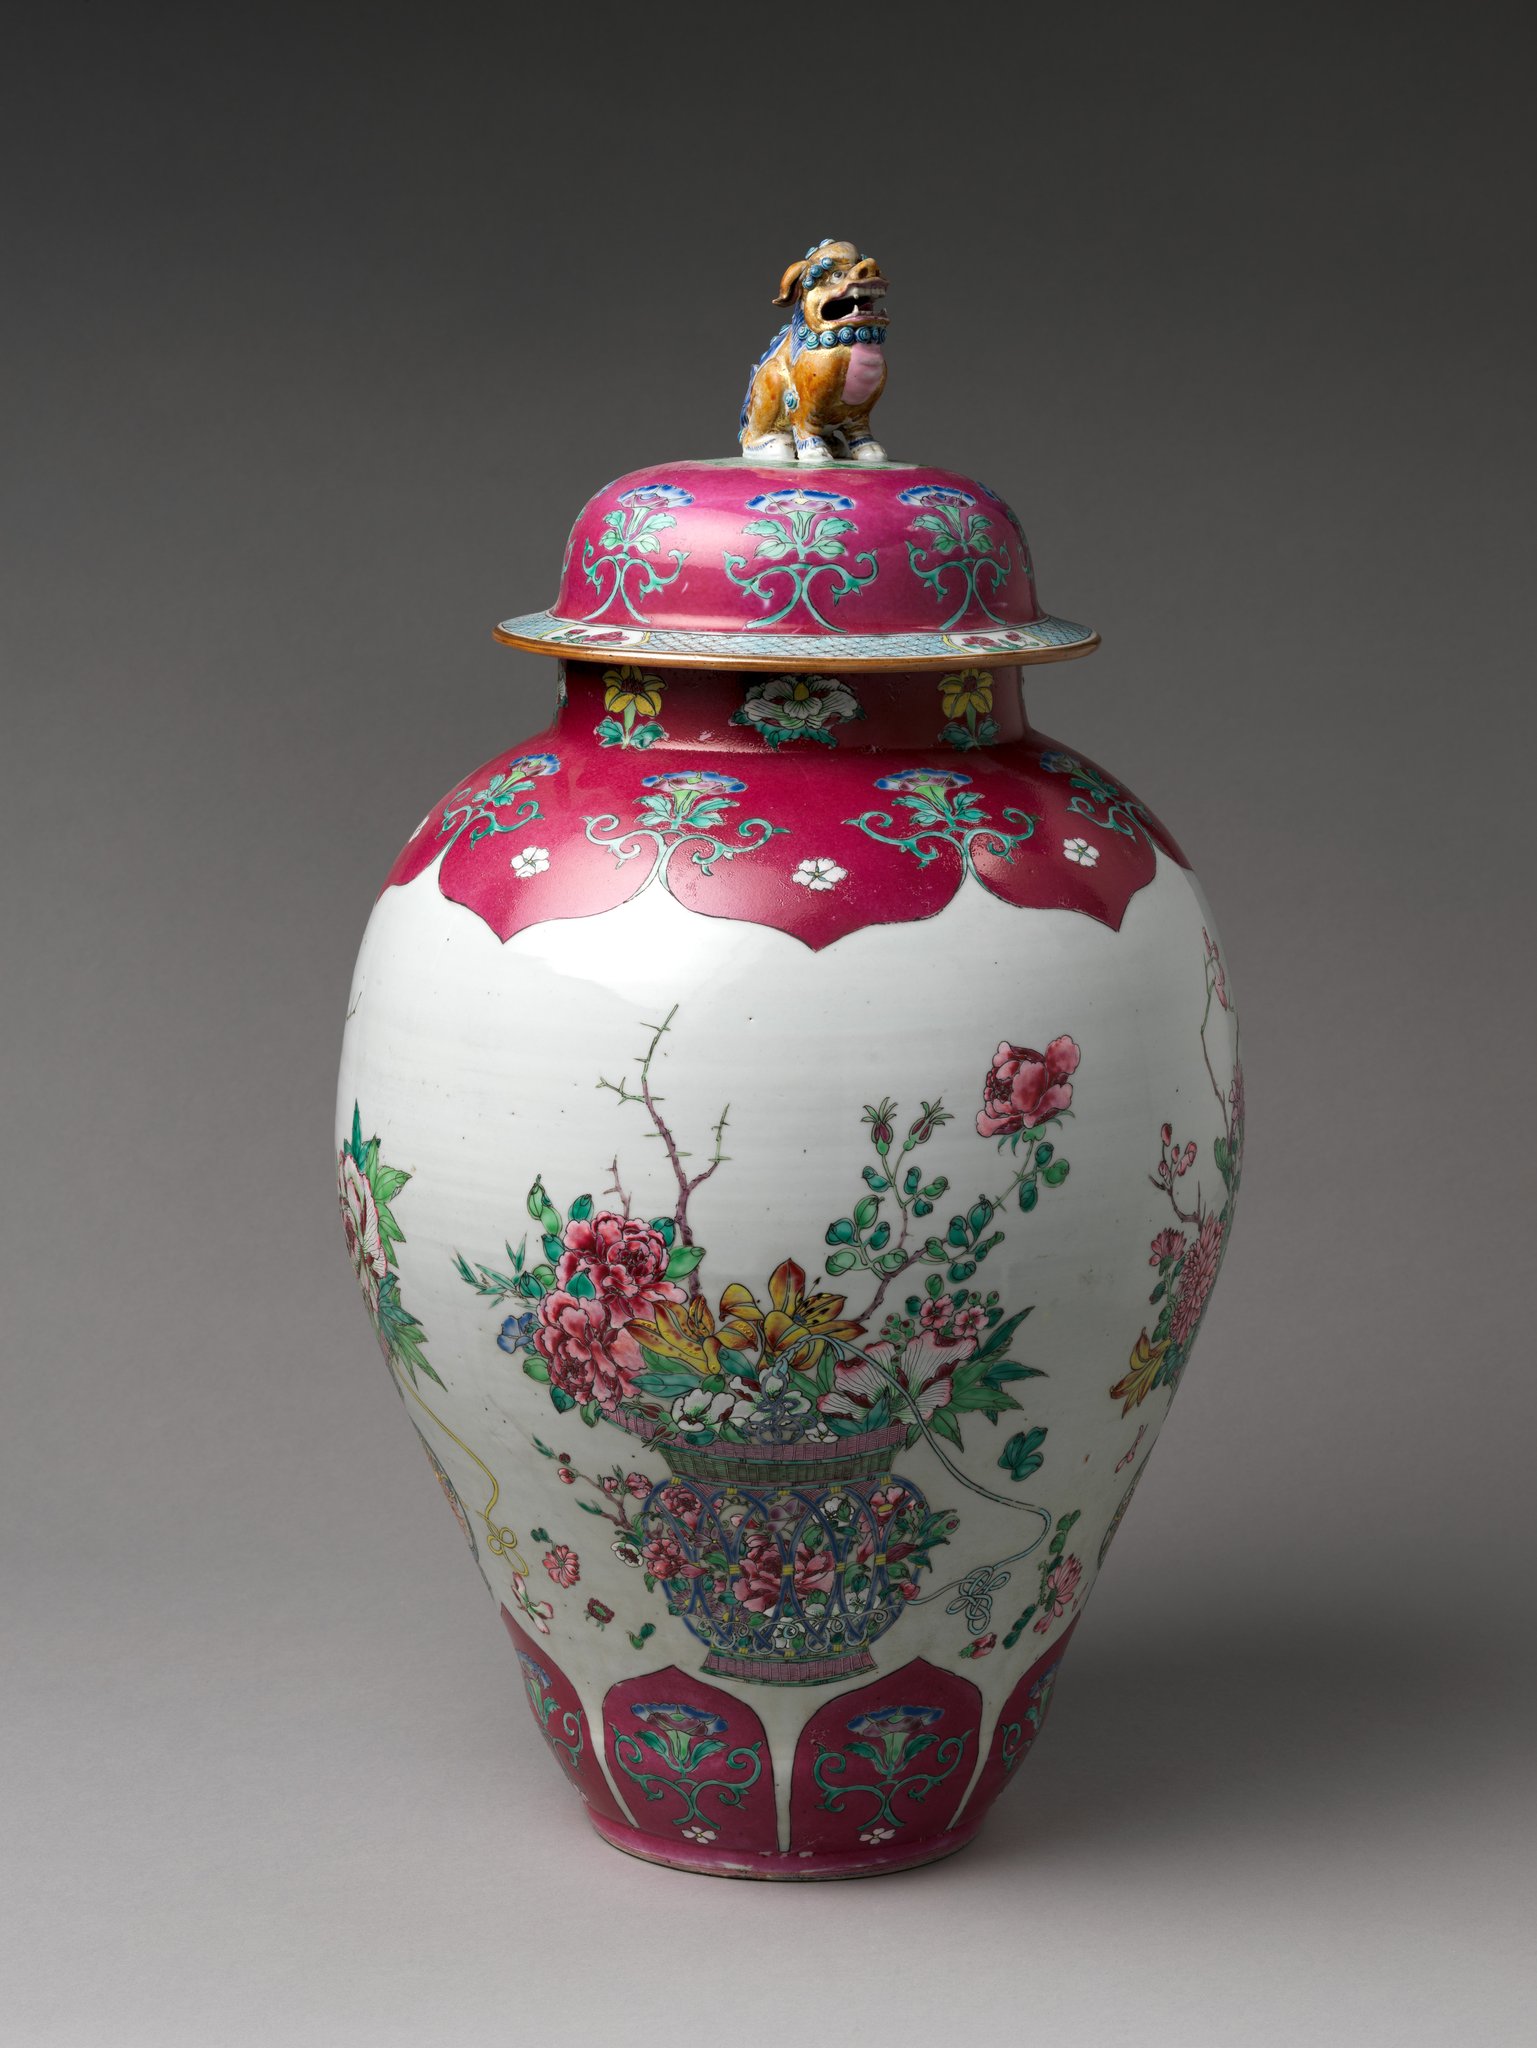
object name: jar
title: Jar with Basket of Auspicious Flowers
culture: chinese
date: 1701-1800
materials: enamel, glaze, porcelain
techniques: painting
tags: flowers,leaves